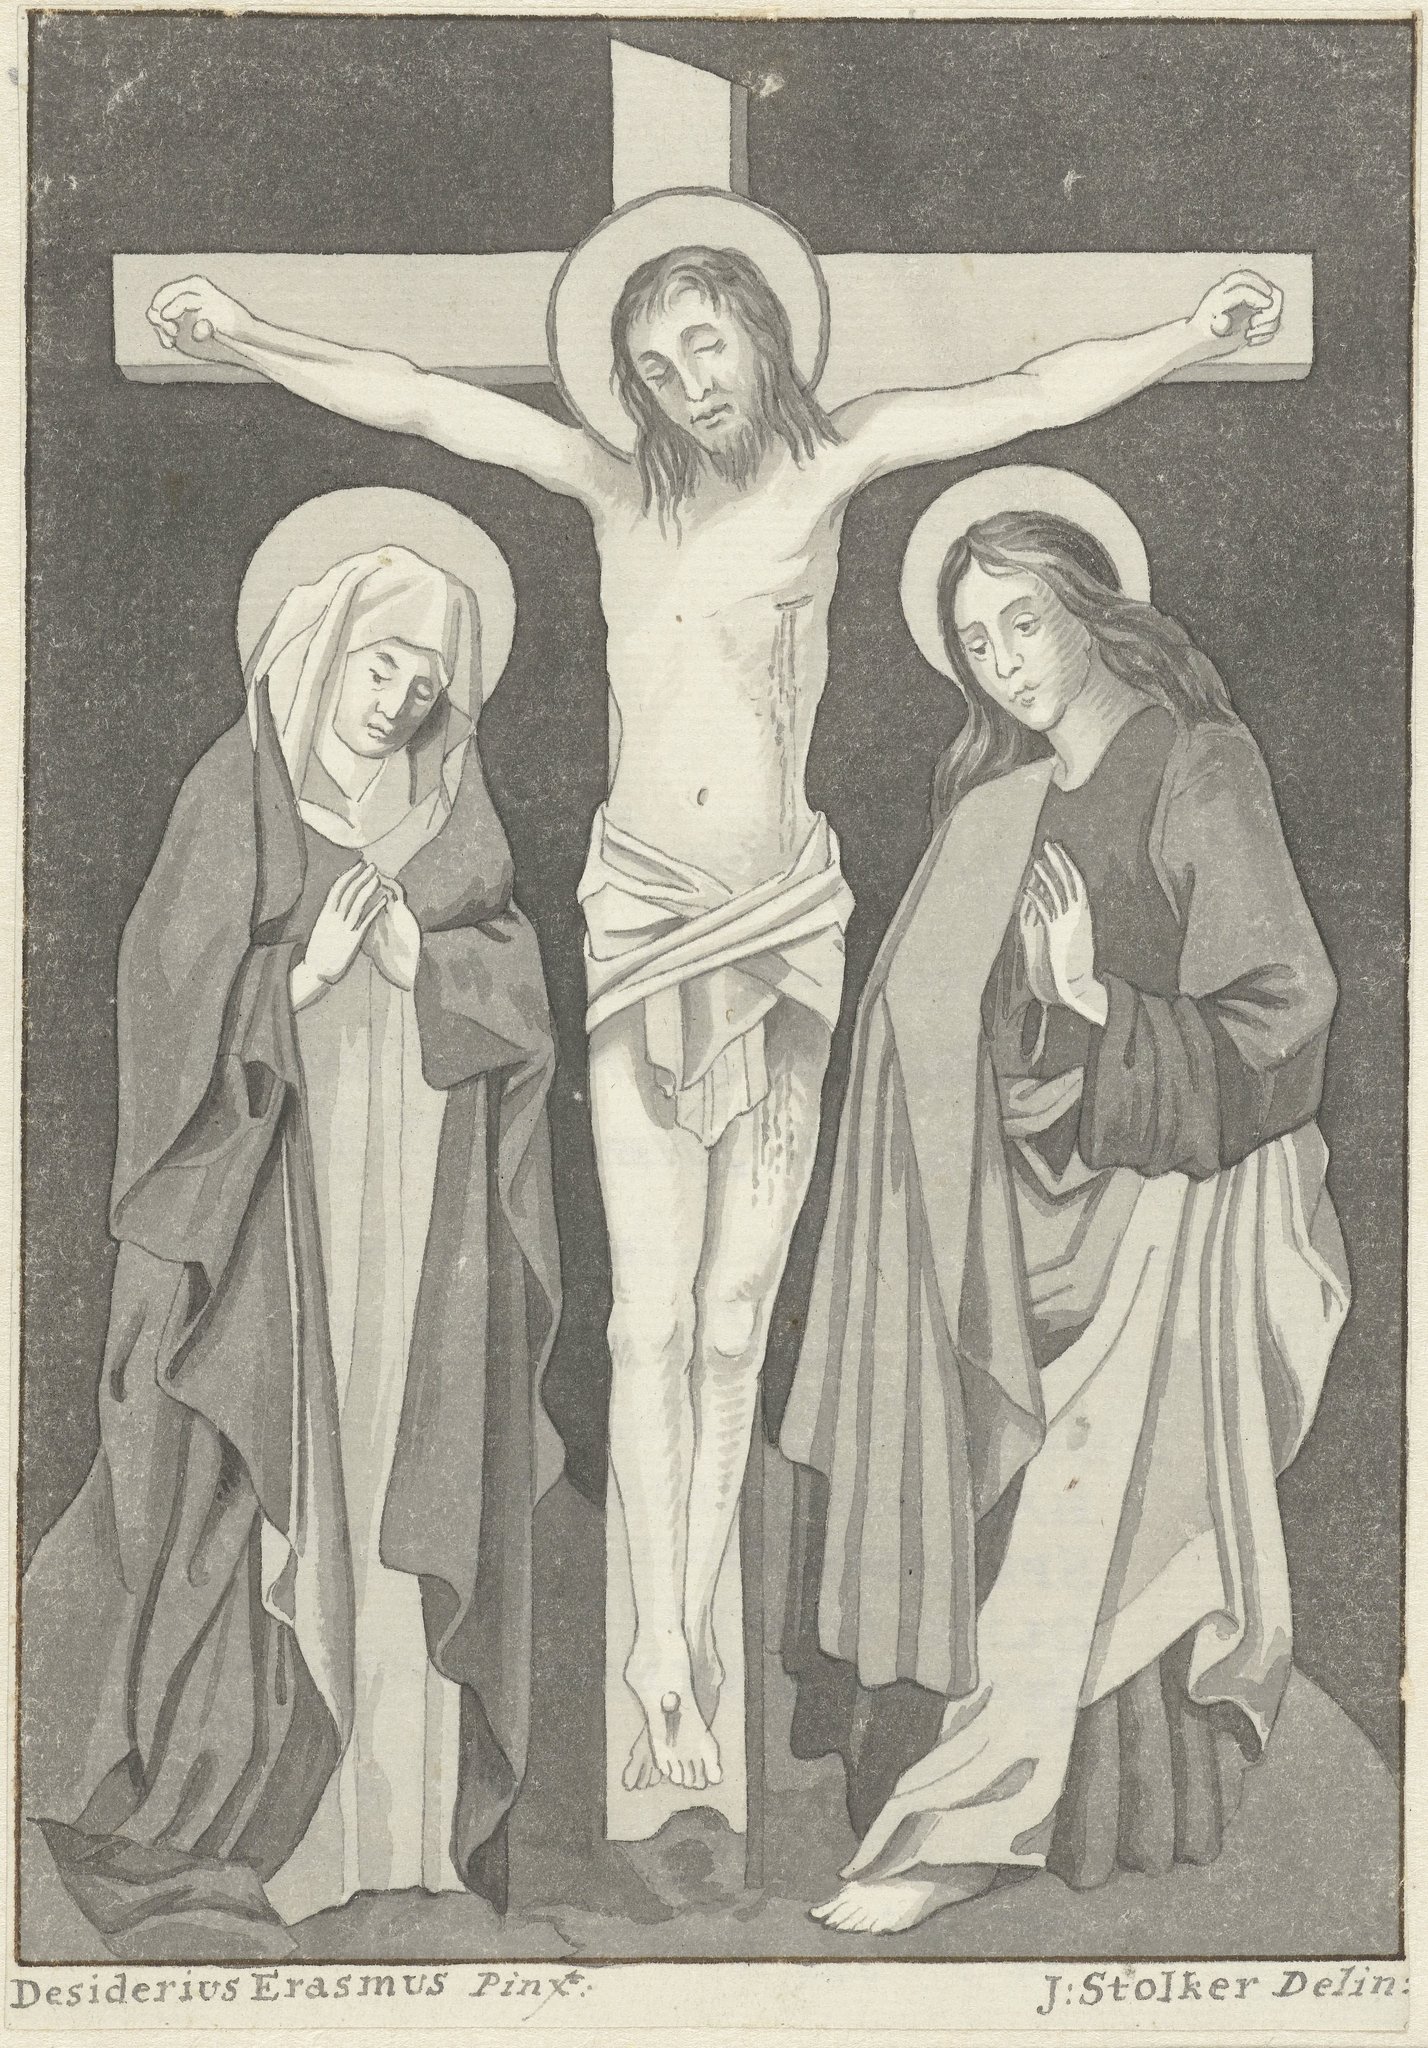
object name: drawing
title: Christus aan het kruis met Maria en Johannes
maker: jan stolker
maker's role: draughtsman, painter, print maker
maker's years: 1724-1785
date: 1734-1785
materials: ink, paper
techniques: brush, pen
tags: desiderius erasmus, bystanders at the foot of the cross, among whom mary, mary magdalene and john the evangelist; mary may be shown swooning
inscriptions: : ‘Onder: Desiderius Erasmus Pinx.: / J: Stolker Delin: Opschrift verso: Naaukeurige Coppy van Het Tafreel door / Desiderius Erasmus geschildert, waar van / wel Eer bezitter was den ongelukkigen Heer / Cornelius Musius [...]/ naderhand en groten / Konstschilder Jacob de wit 't Amsterdam. / Rondom de lyst staat met gouden letteren / HAEC DESIDERIUS [NE SPERNAS] PINXIT ERASMUS OLIM. IN STEINAEO QUANDO LATEBATAGRO. / [sign:] J. Stolker’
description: Tekening naar een schilderij geschilderd door Erasmus, ca. 1487 of 1501.